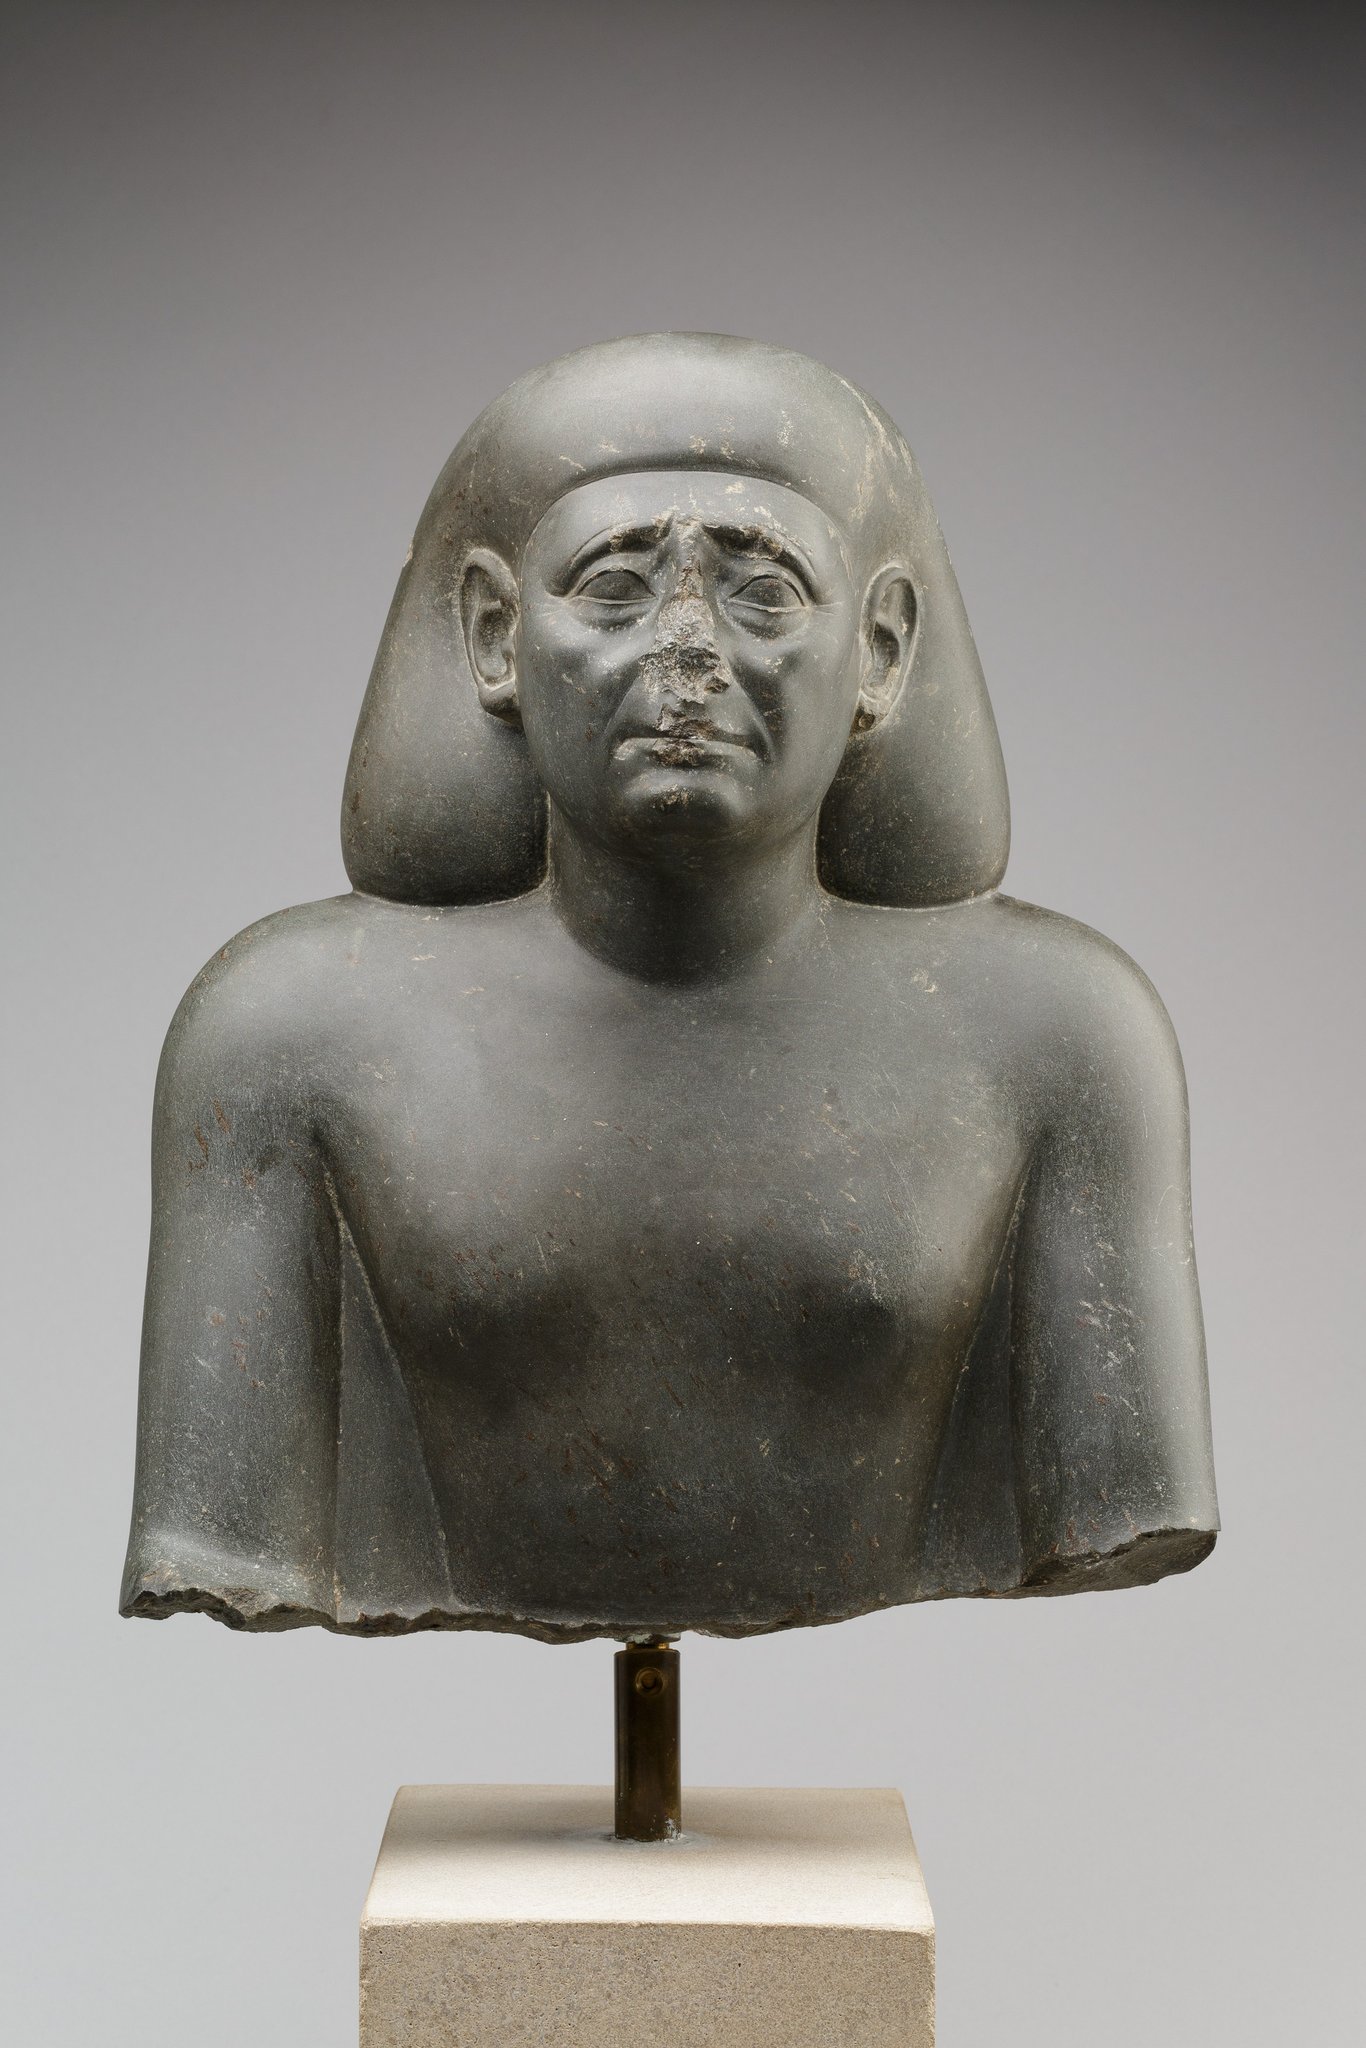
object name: bust, official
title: Bust of an Official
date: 380-343 BCE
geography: memphite region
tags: sadness,men